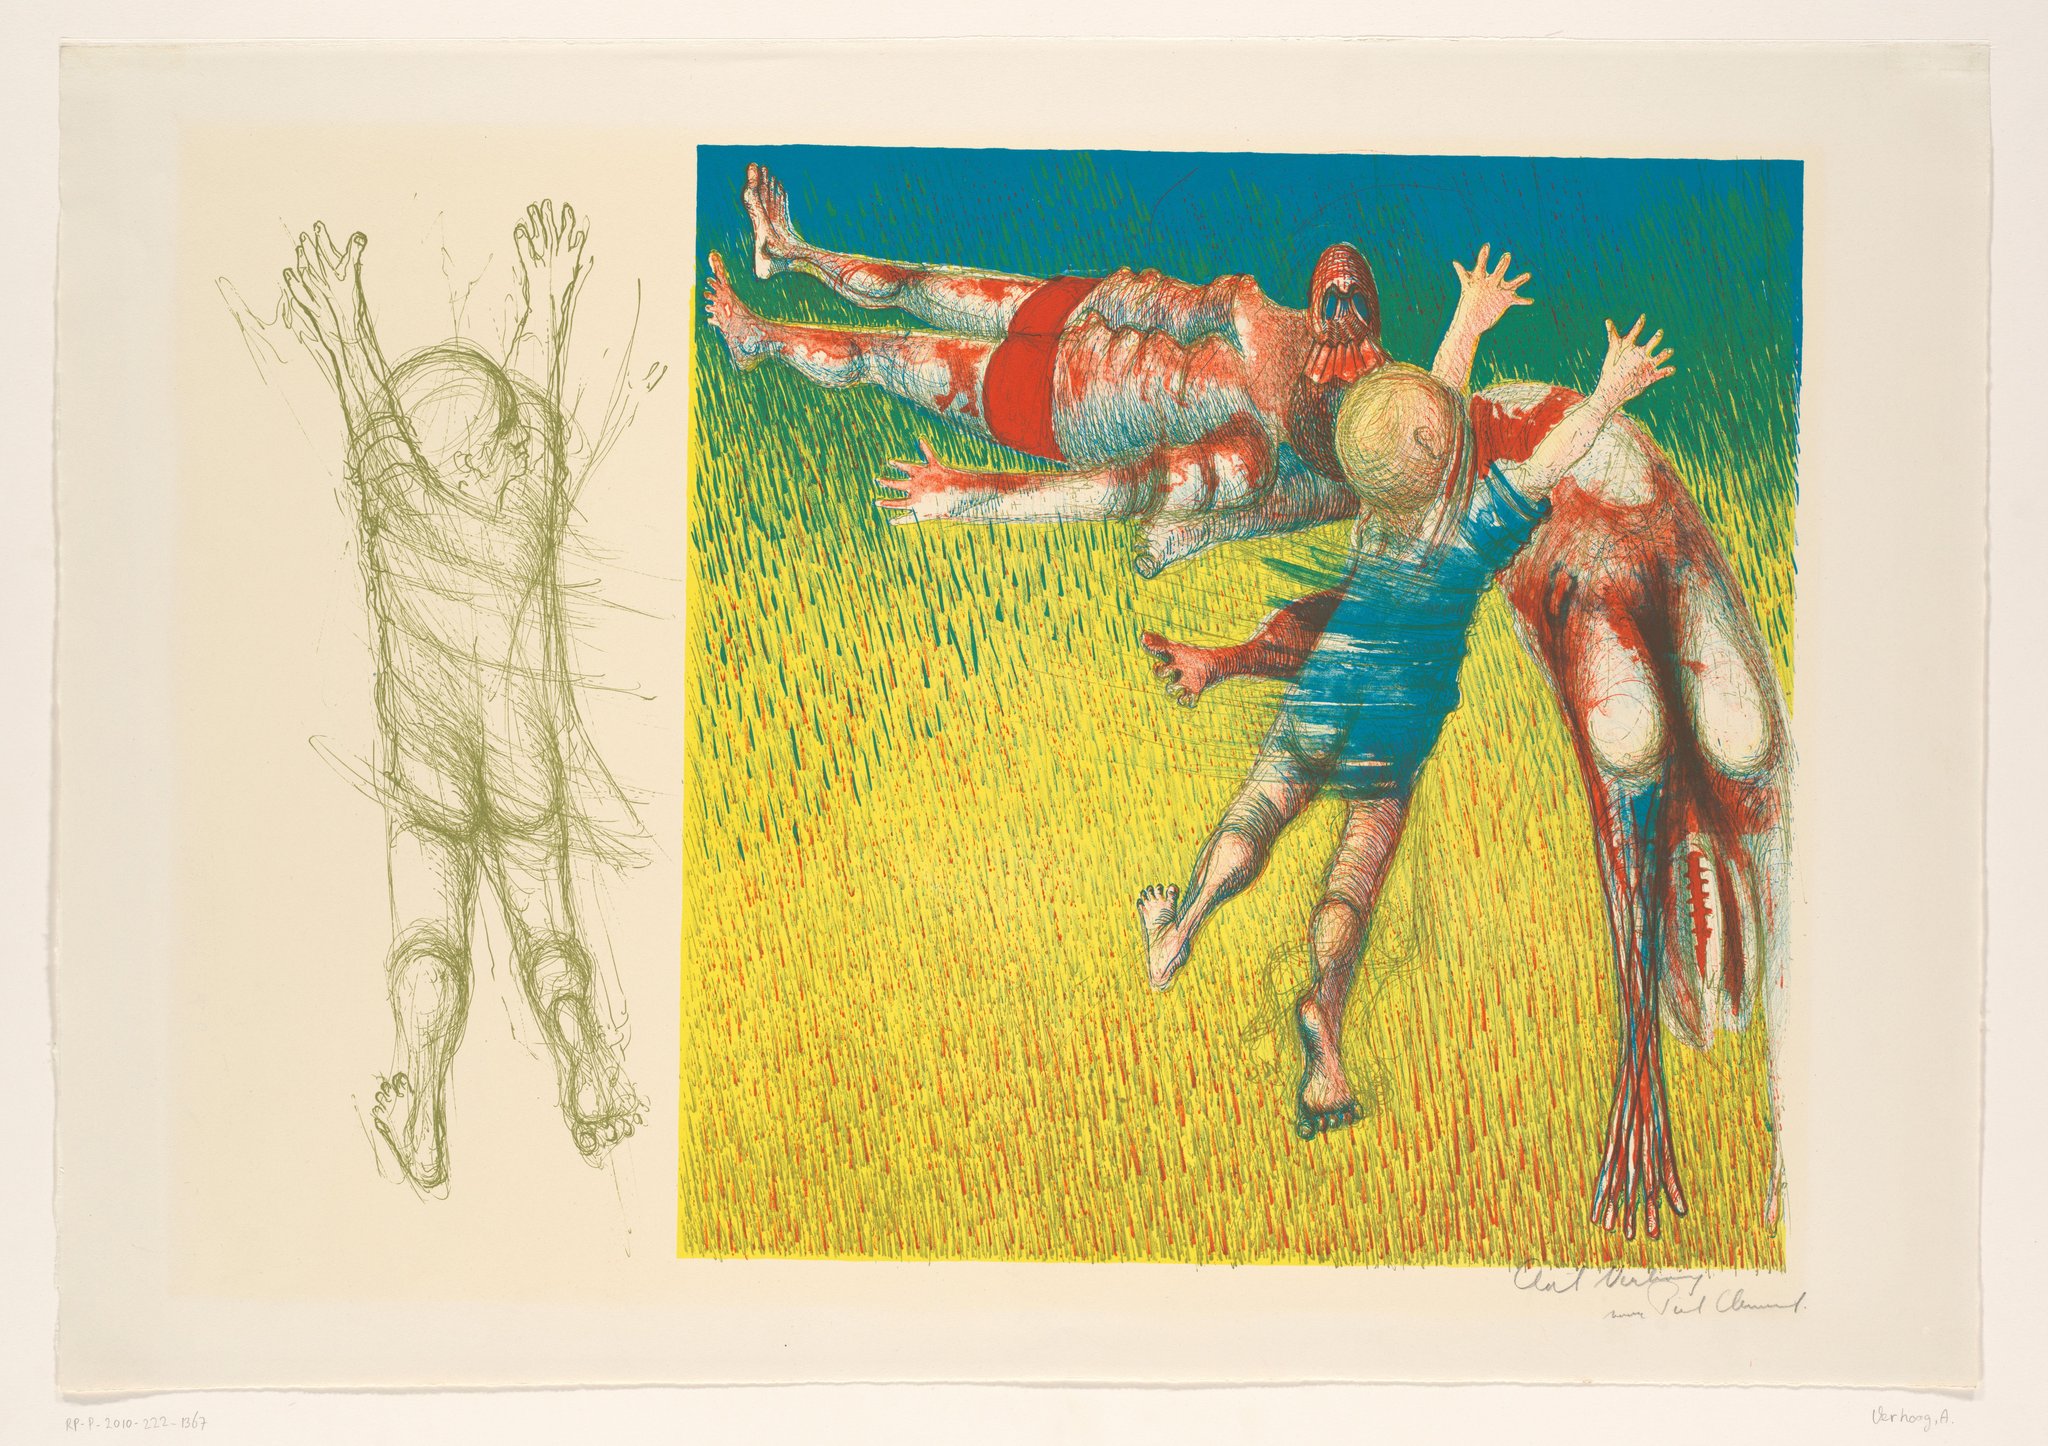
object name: print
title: Liggende figuren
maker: aat verhoog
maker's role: print maker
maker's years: 1933-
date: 1966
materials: paper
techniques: lithograph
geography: amsterdam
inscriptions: signature: ‘Aat Verhoog’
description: Liggende figuren; links een naakte man met uitgestrekte armen opgezet in groene lijnen tegen witte achtergrond, rechts drie schaars geklede figuren tegen gekleurde achtergrond.